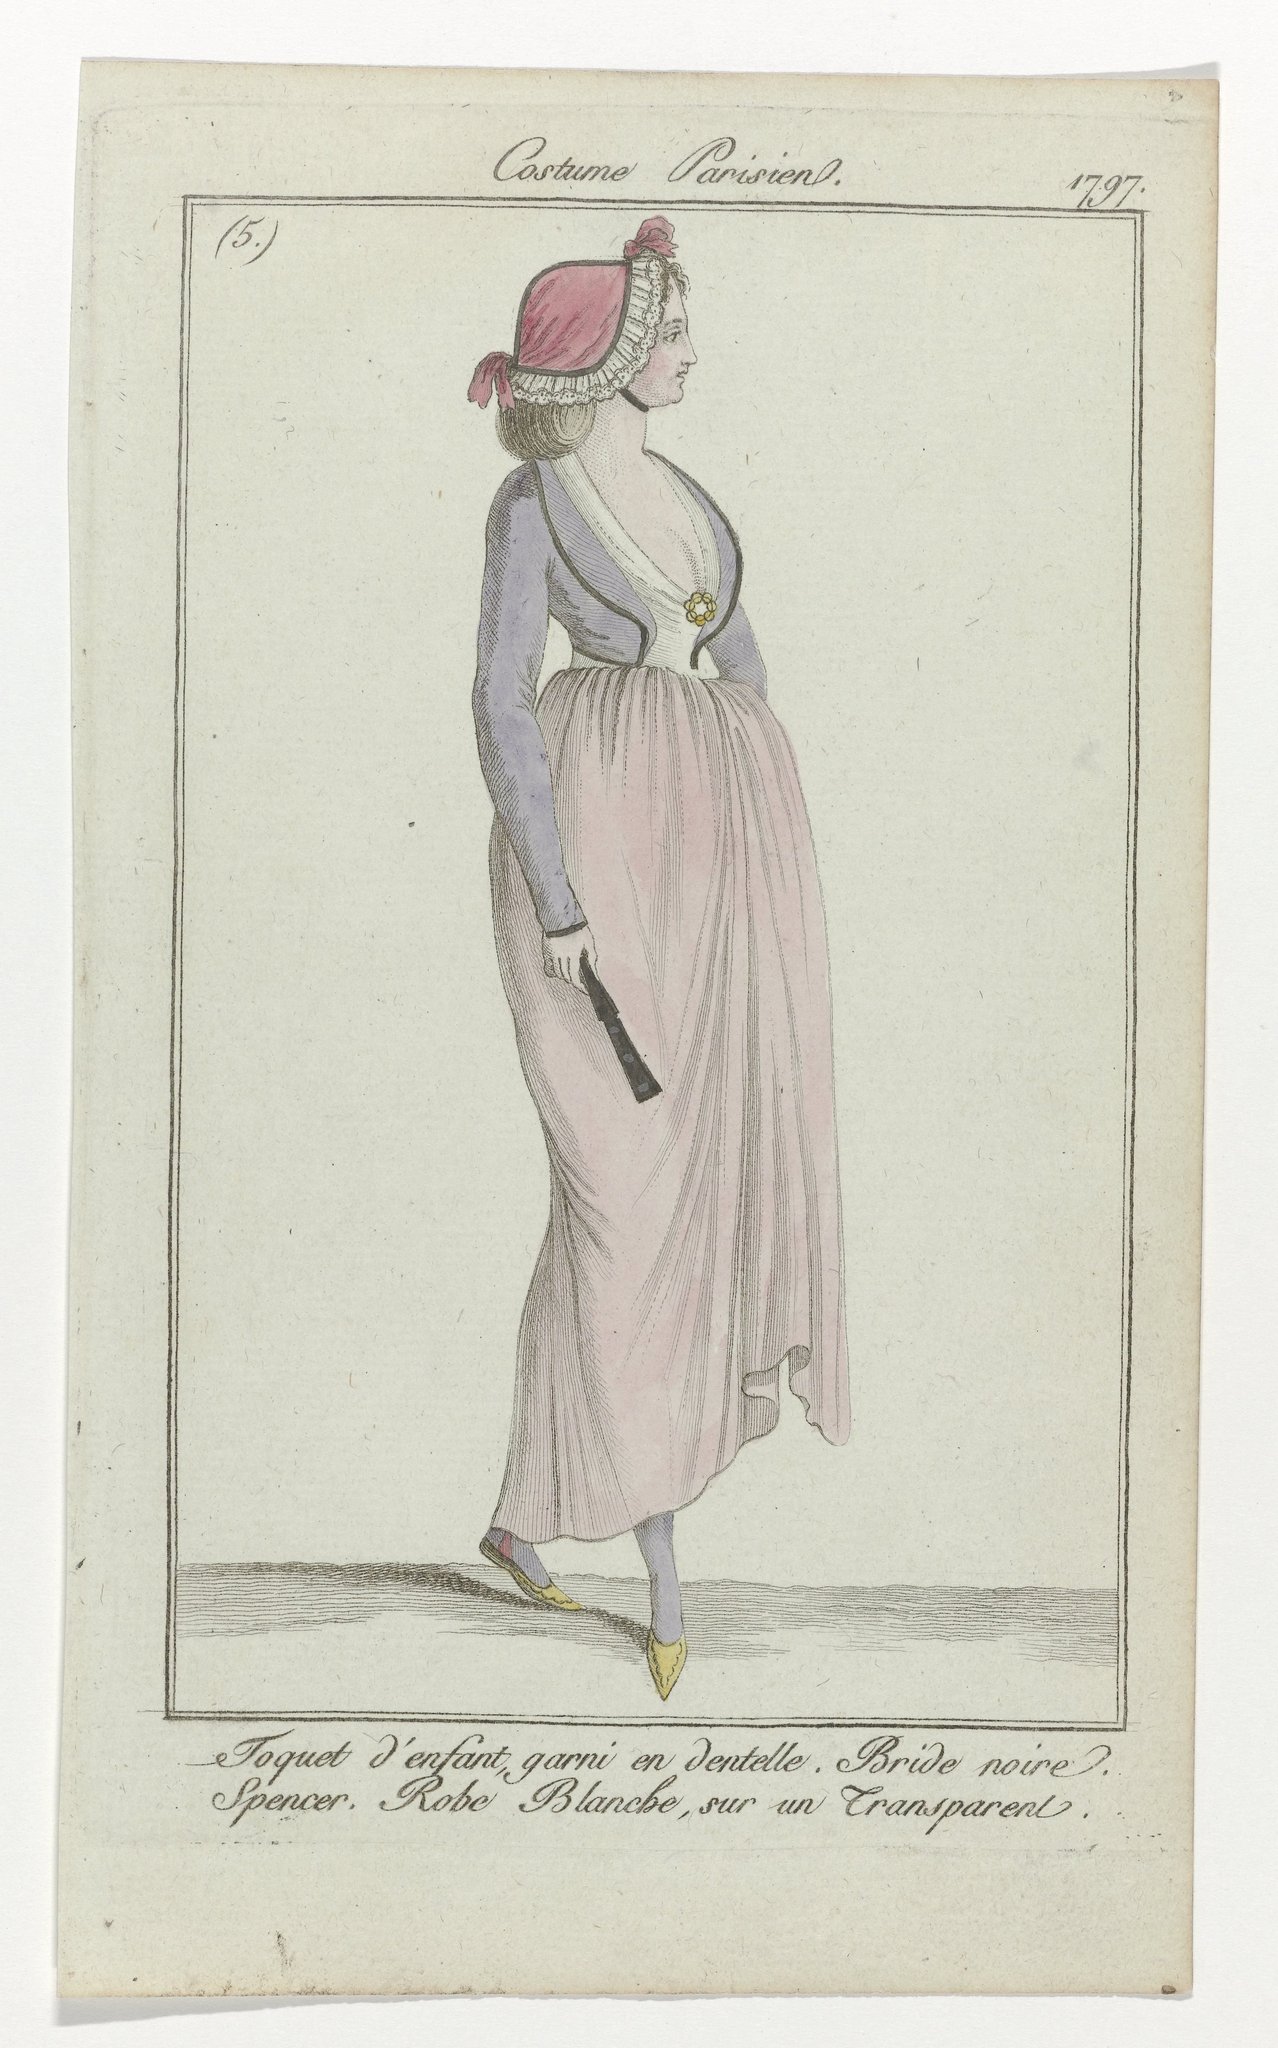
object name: fashion print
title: Journal des Dames et des Modes, Costume Parisien, 16 septembre 1797, (5): Toquet d'enfant garni en dentell (...)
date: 1797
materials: paper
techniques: engraving, hand coloring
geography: paris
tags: head-gear: toque (+ women's clothes), border, ribbon, braid (+ women's clothes), lace (+ women's clothes), underclothes for the lower part of the body (underskirt) (+ women's clothes), clothing for the upper part of the body (spencer) (+ women's clothes), fashion plates, shoes, sandals (+ women's clothes), dress, gown (+ women's clothes), stockings, socks (+ women's clothes), fan (+ women's clothes)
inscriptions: caption: ‘Toquet d'enfant garni en dentelle. Bride noire. Spencer. Robe Blanche, sur un Transparent.’, title: ‘Costume Parisien.’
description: 'Toquet d'enfant' gegarneerd met kant. Spencer met zwarte bies. Witte japon over een 'Transparent' (onderrok). Gekleurde kousen met contrasterende klinken. Verdere accessoires: broche(?), waaier, platte schoenen met puntige neuzen. De prent maakt deel uit van het modetijdschrift Journal des Dames et des Modes, uitgegeven door Sellèque, Parijs, 1797-1839. Deze prent werd eerder uitgegeven in het Journal des Modes et Nouveautés als nummer 5, met het onderschrift 'Costumes'.